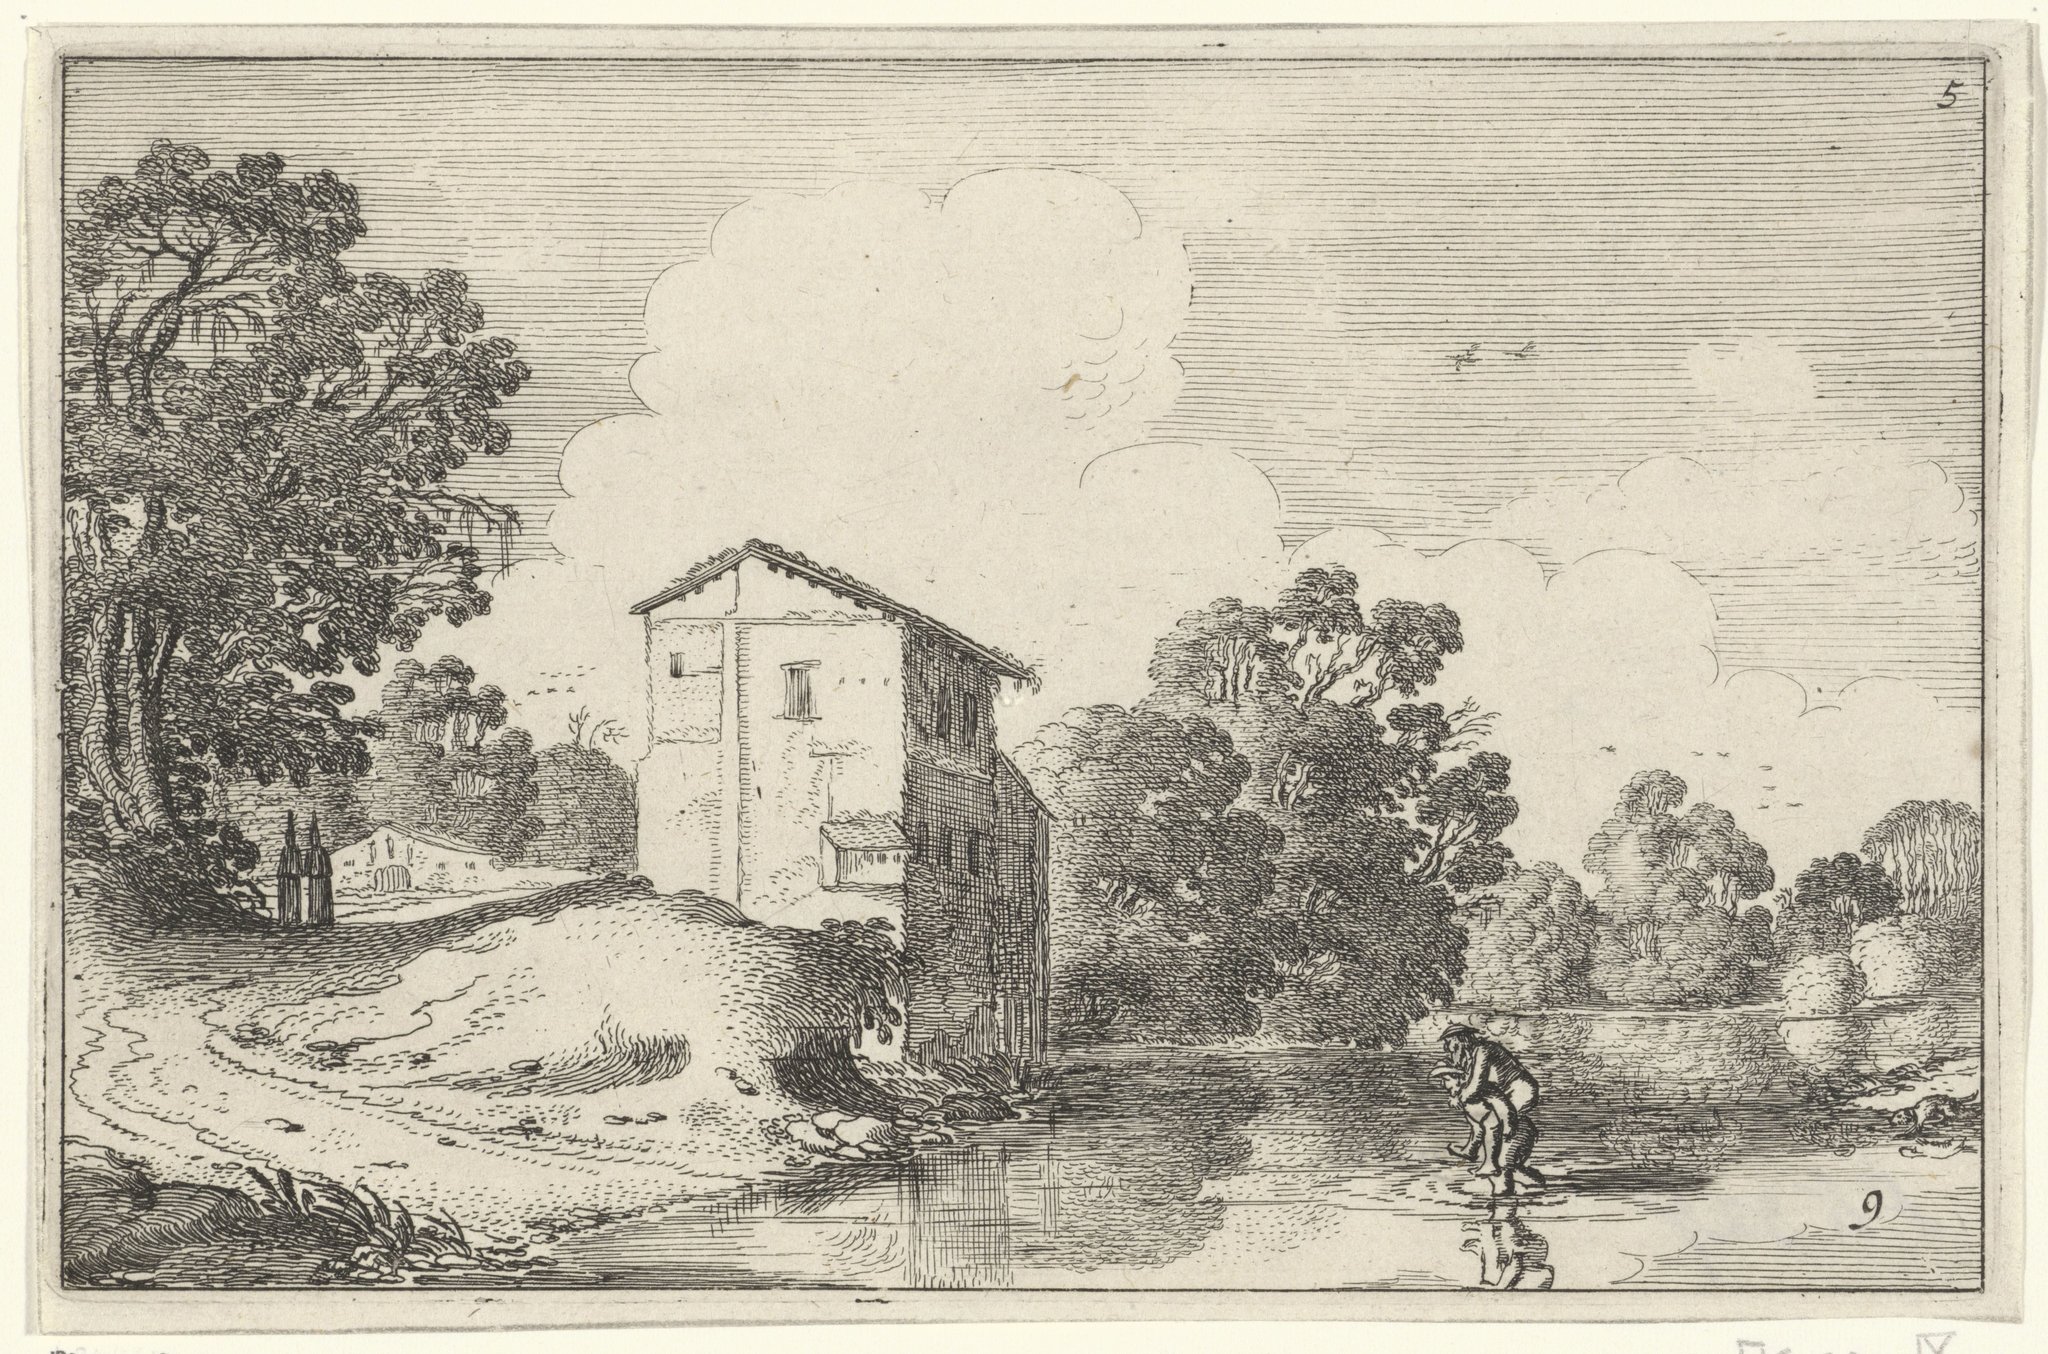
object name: print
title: Amenissimae aliquot requculae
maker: jan van de velde (ii)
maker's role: draughtsman, painter, print maker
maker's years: 1593-1641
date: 1616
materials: paper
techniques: etching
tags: ford, carrying a person on one's back, farm or solitary house in landscape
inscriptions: collector's mark: Lugt 964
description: Twee figuren doorwaden een rivier bij een huis. Een figuur draagt de ander op zijn rug. Links op een pad twee geestelijken. Negende prent van deel vijf van een serie van in totaal zestig prenten met landschappen, verdeeld over vijf delen van elk twaalf prenten.